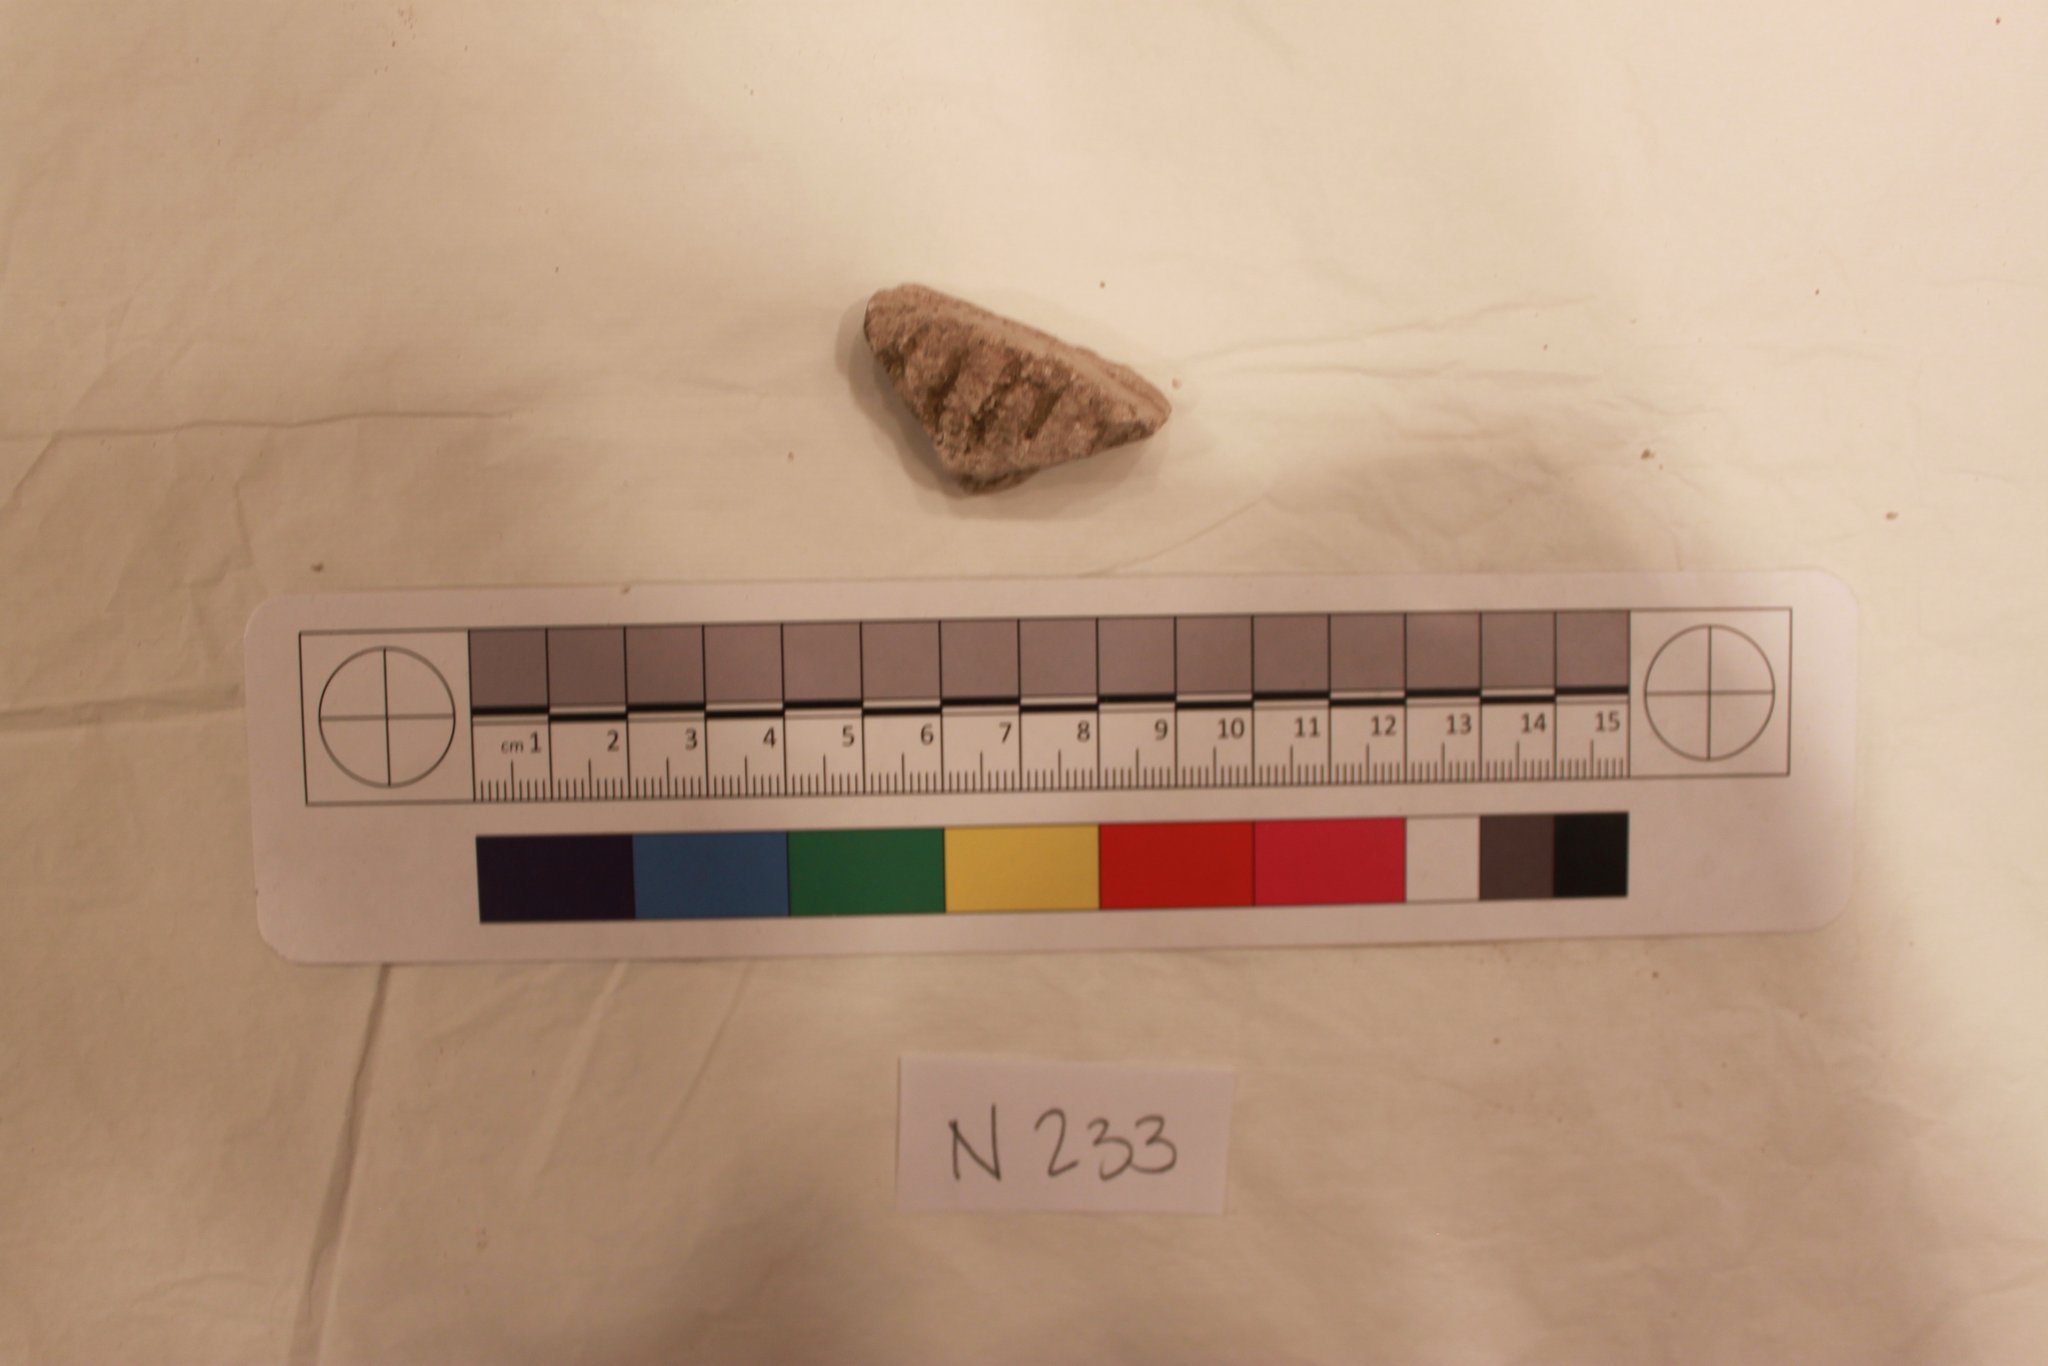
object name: fragment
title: Stucco Fragment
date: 701-1200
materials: plaster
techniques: carving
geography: iran